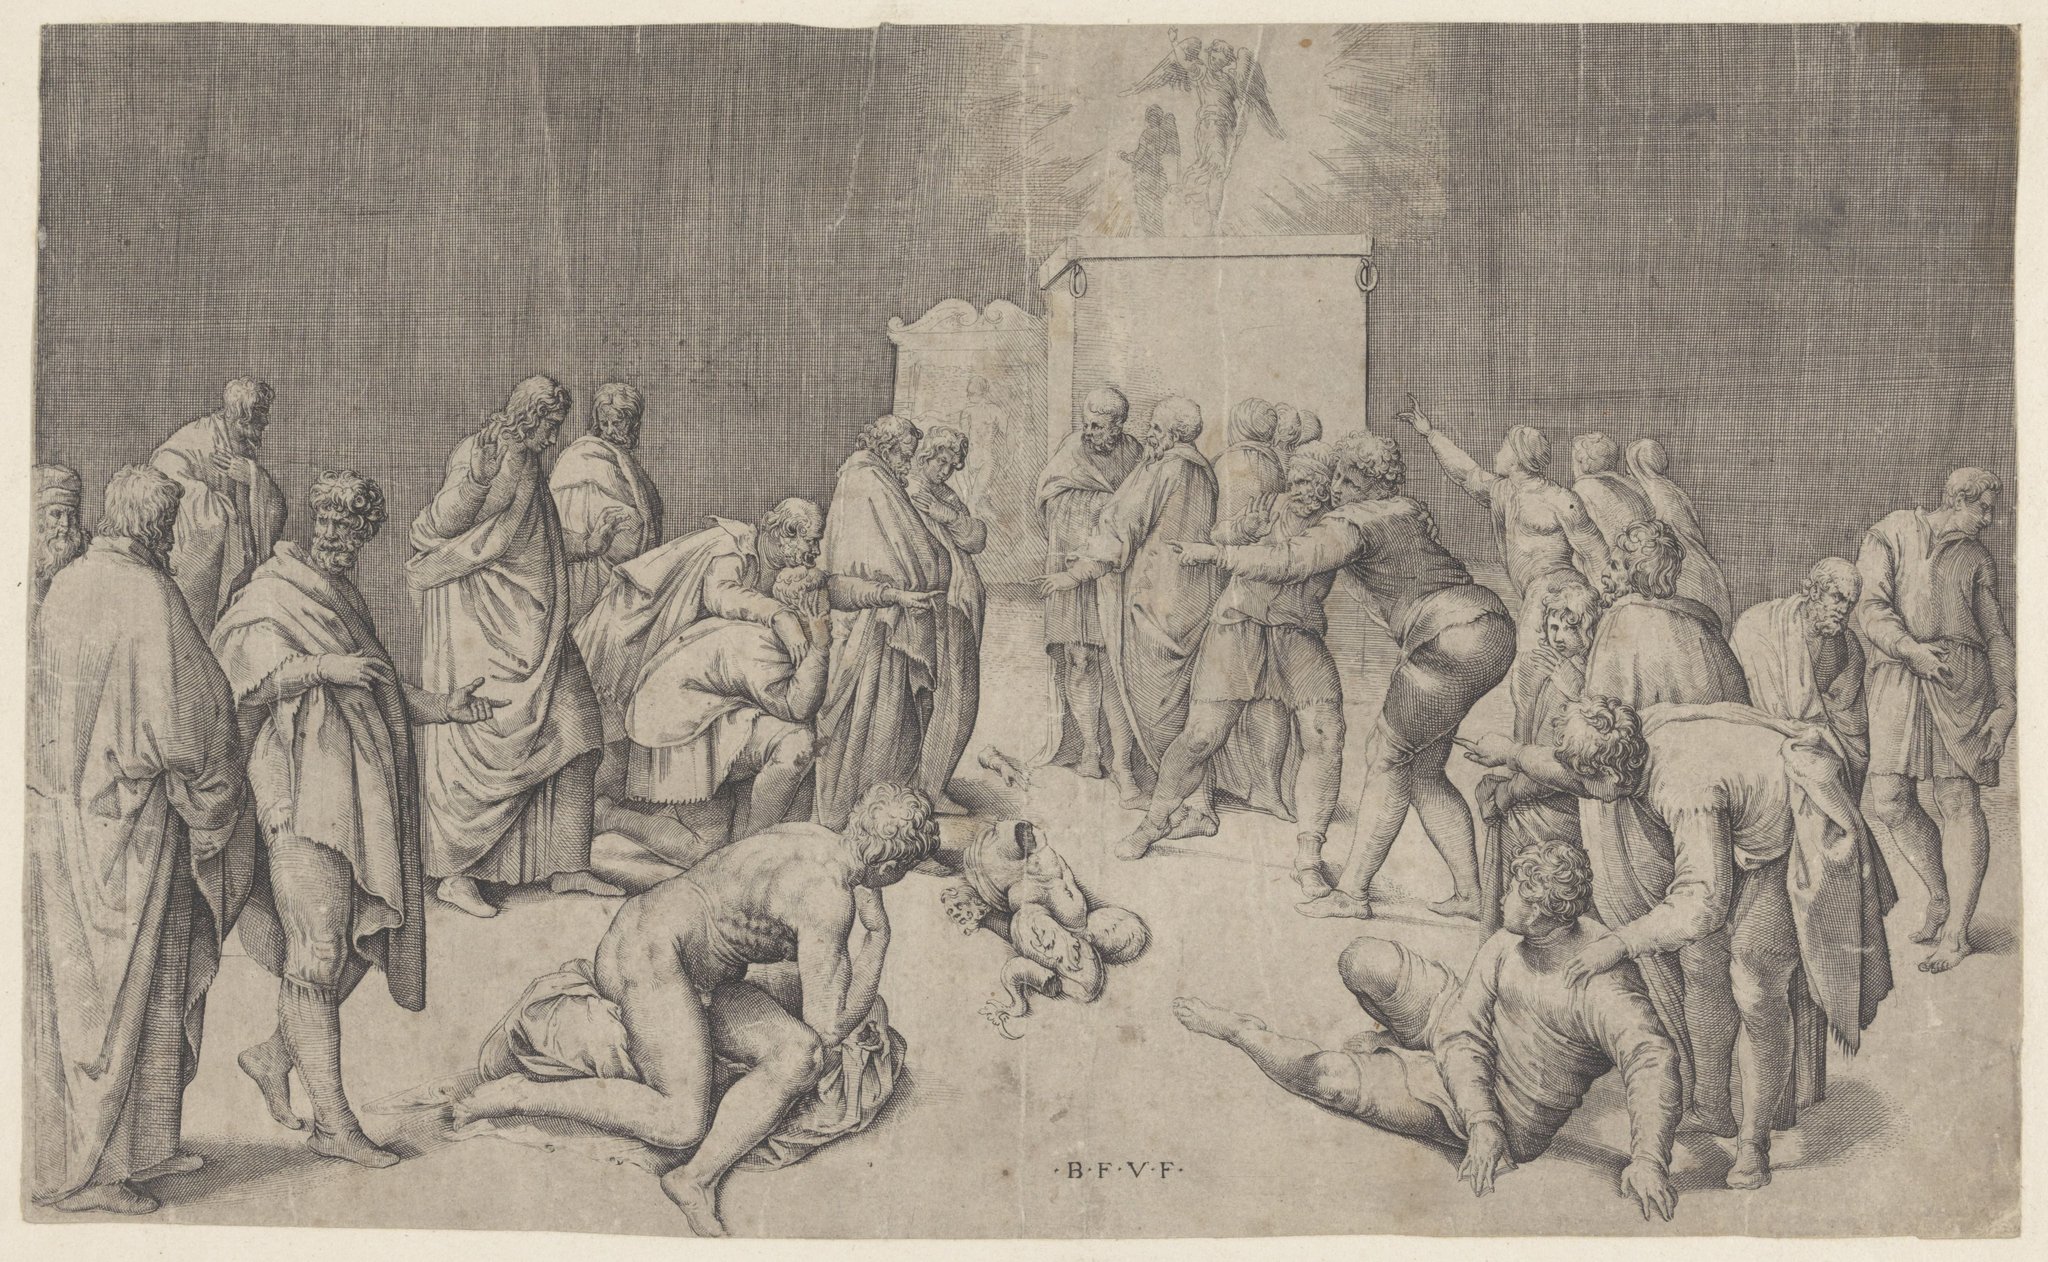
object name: print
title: Ark des Verbonds in de tempel van Dagon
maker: battista franco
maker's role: draughtsman, painter, print maker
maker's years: 1510-1561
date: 1520-1561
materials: paper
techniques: etching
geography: italy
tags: the statue of dagon in ashdod falls down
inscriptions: collector's mark: Lugt 240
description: De Filistijnen plaatsen de Ark des Verbonds in de tempel van Dagon. Stukken van een kapot beeld liggen op de grond.